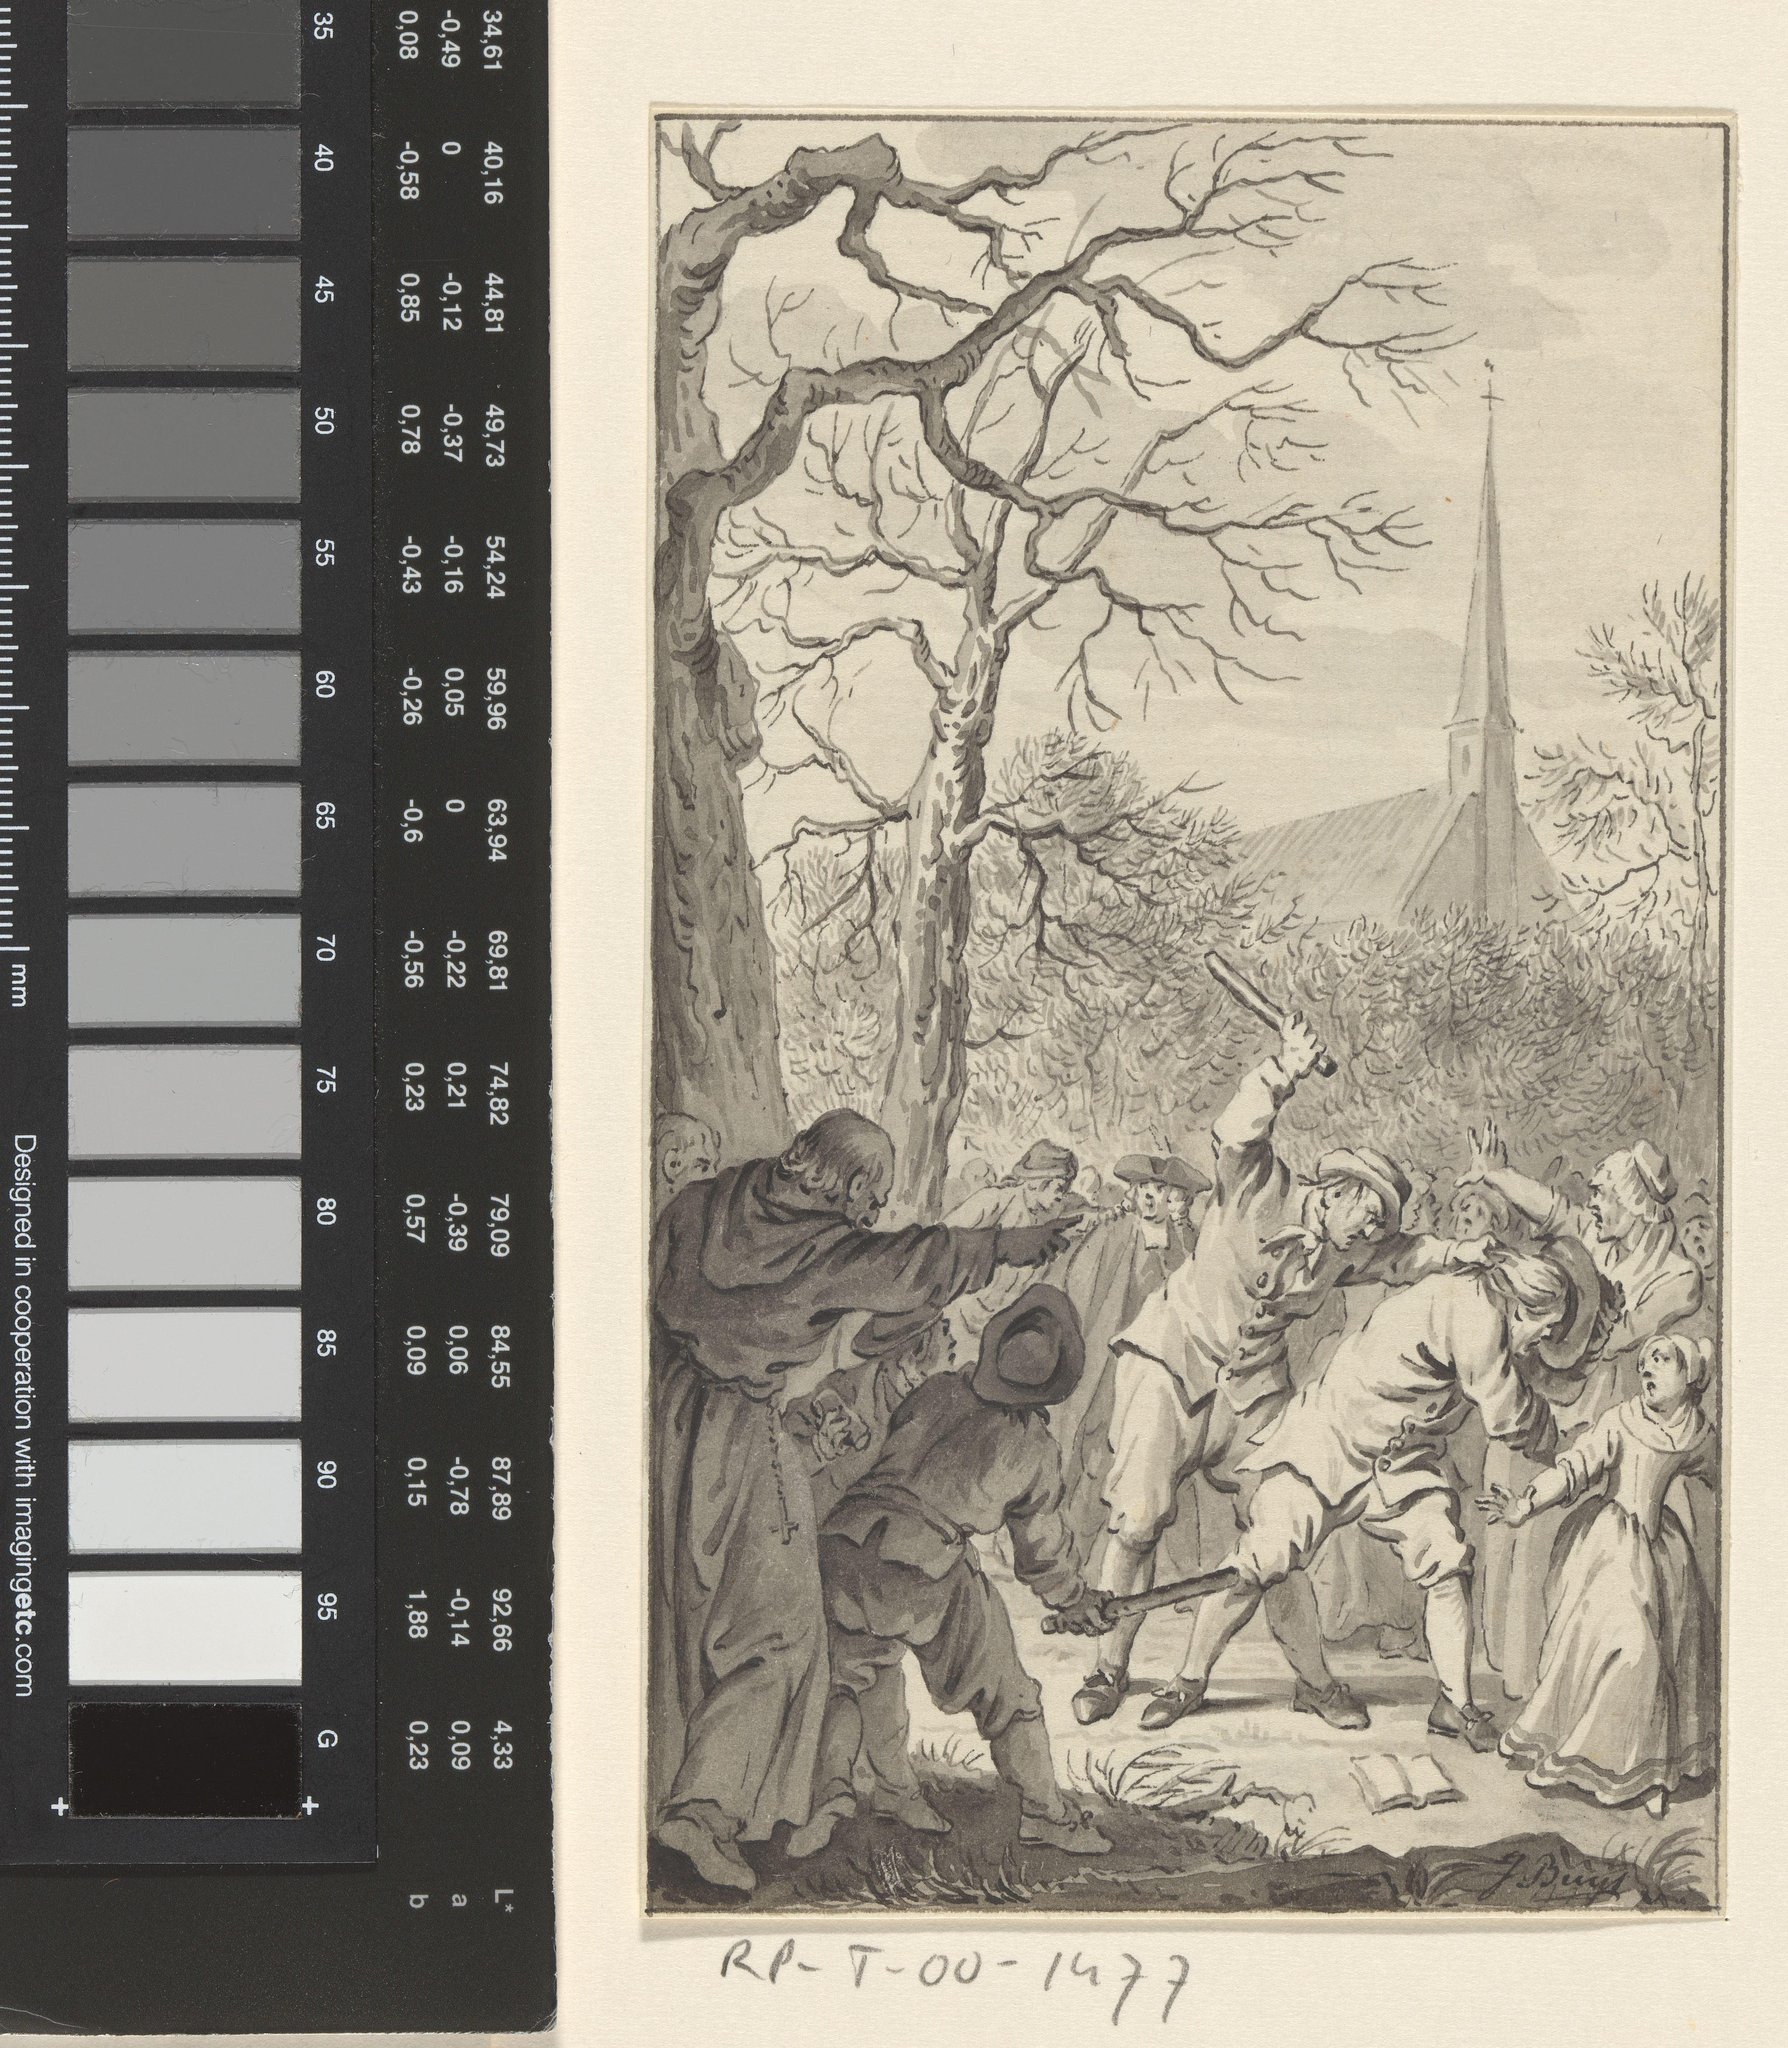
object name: drawing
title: Mishandeling van gereformeerden te Vaals, januari 1764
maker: jacobus buys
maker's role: draughtsman, print maker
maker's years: 1724-1801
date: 1764-1801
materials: ink, paper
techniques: brush, pen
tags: street-fights, riots, historical events and situations